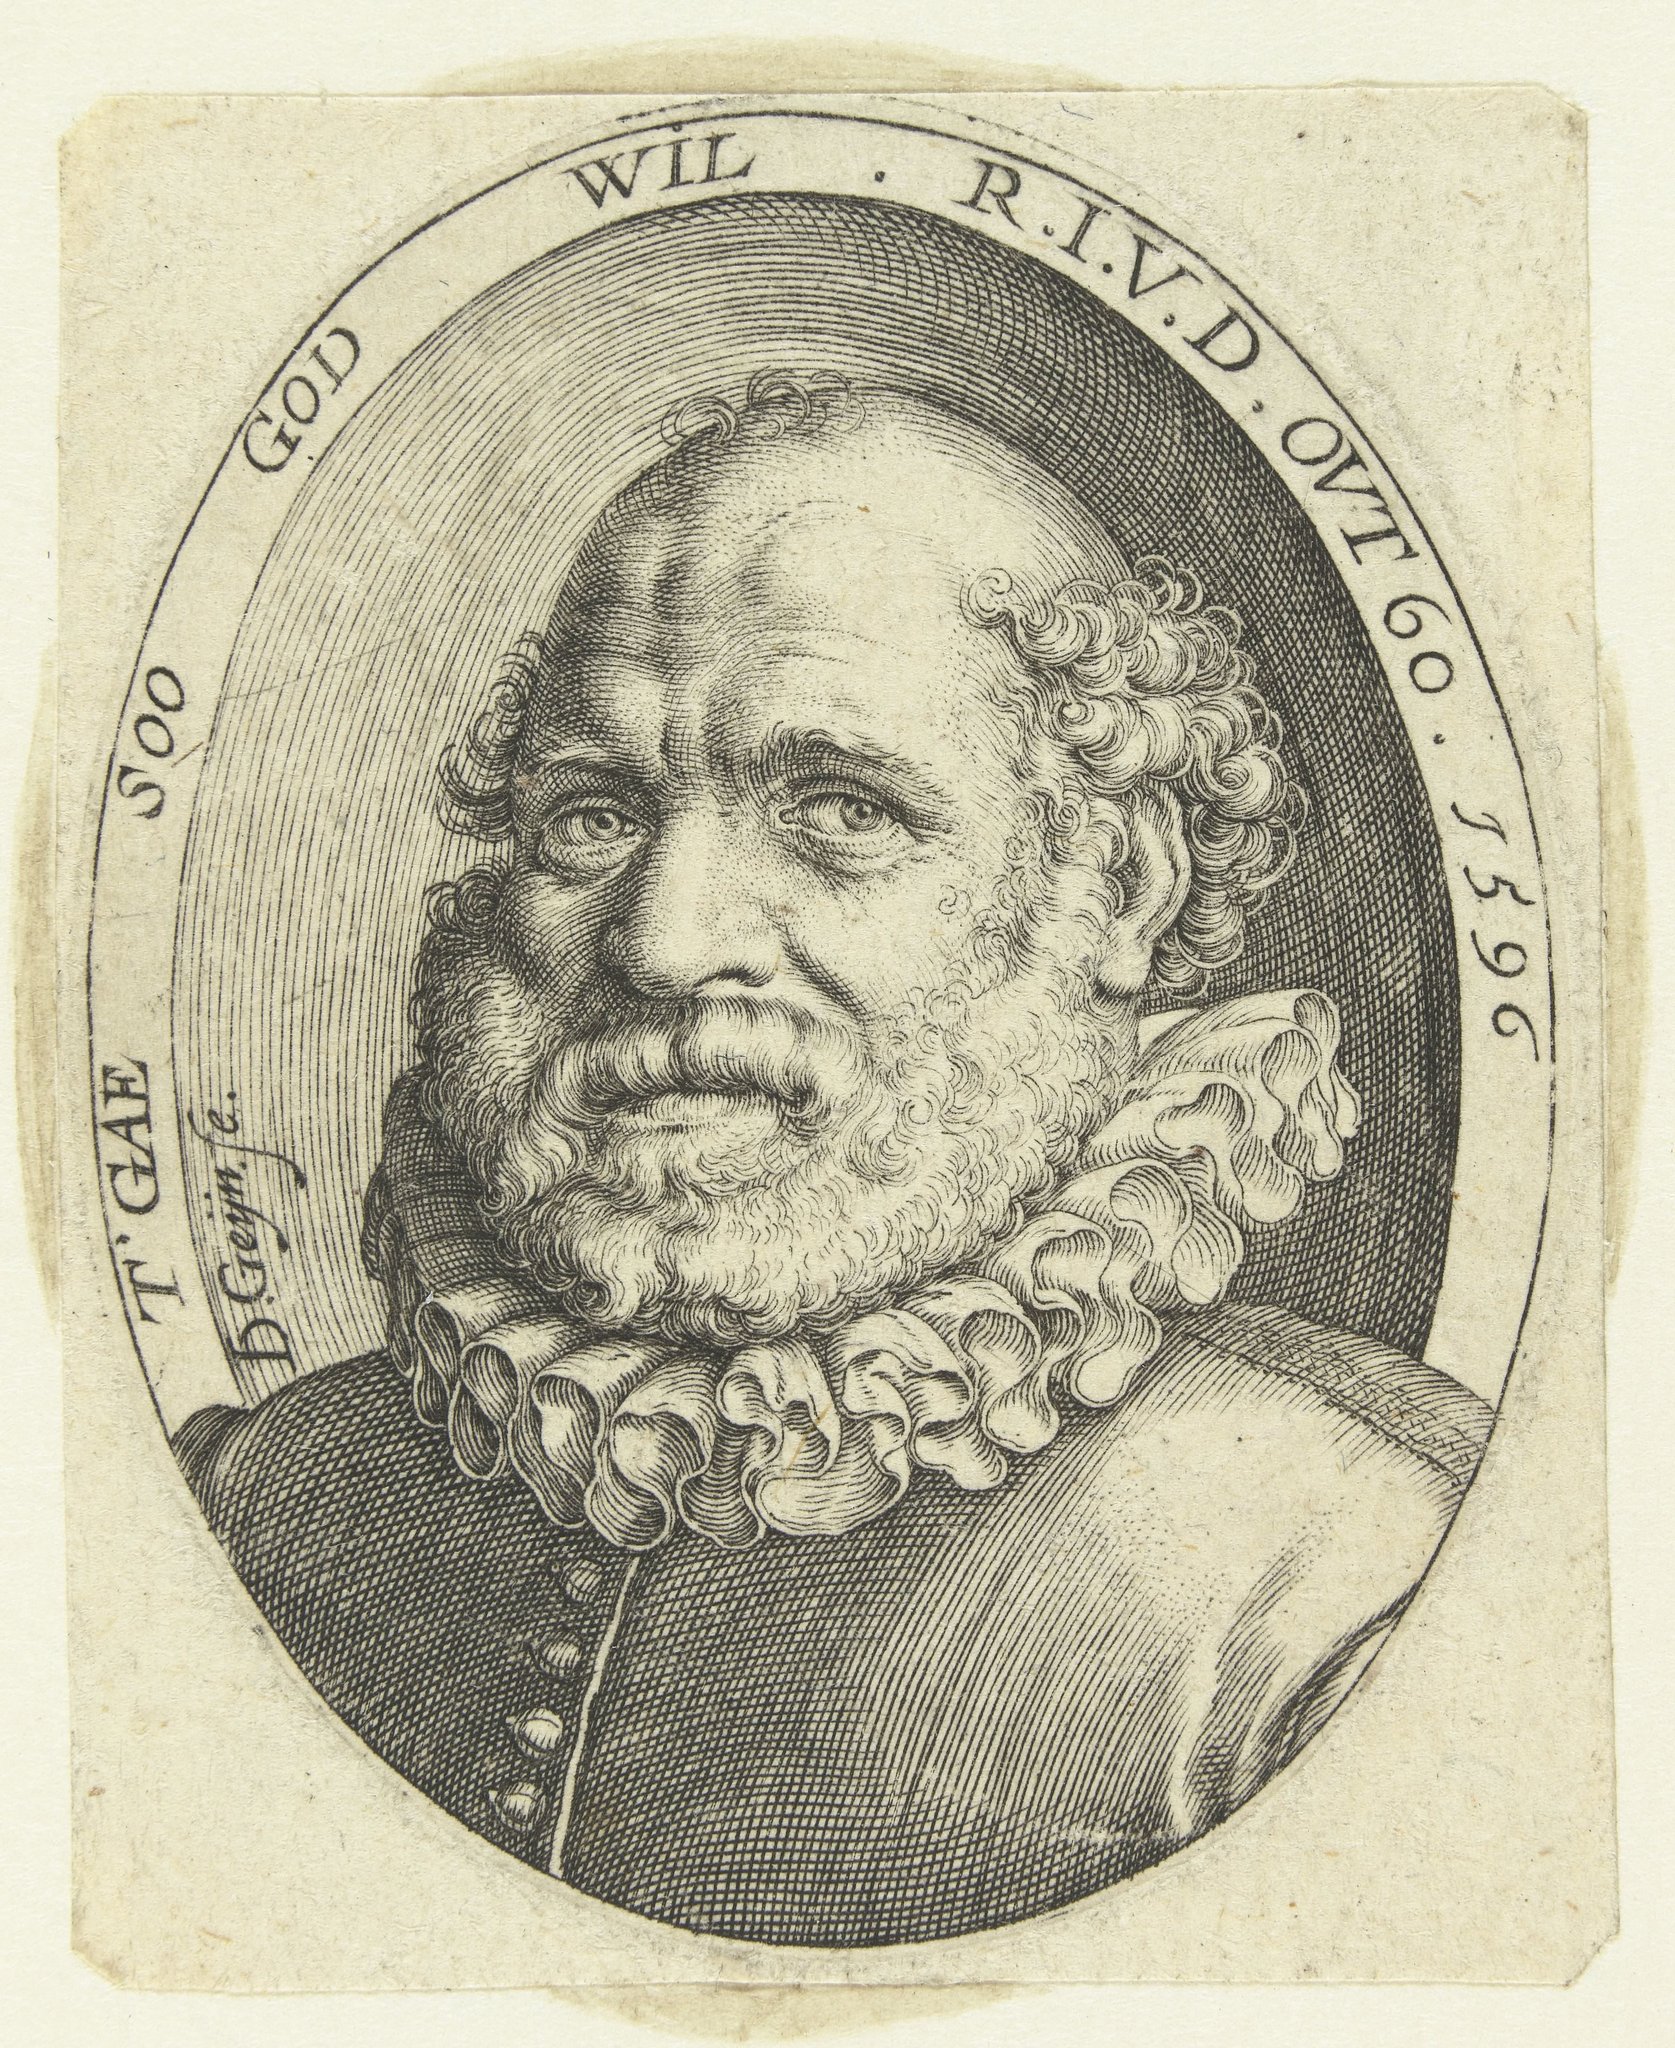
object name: print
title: Portret Rutgaert Jansz. op 60-jarige leeftijd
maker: jacques de gheyn (ii)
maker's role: painter, print maker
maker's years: 1565-1629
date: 1596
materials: paper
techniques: engraving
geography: leiden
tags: historical persons, portrait of a writer (+ artist in non-work situation), armorial bearing, heraldry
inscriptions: collector's mark: Lugt 240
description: Buste van Rutgaert Jansz. (ca. 1536 - ?), op 60-jarige leeftijd, naar links in ovaal met randschrift (motto 'T GAE SOO GOD WIL'). Jansz. was schrijver en lid van rederijkerskamer De Eglentier.